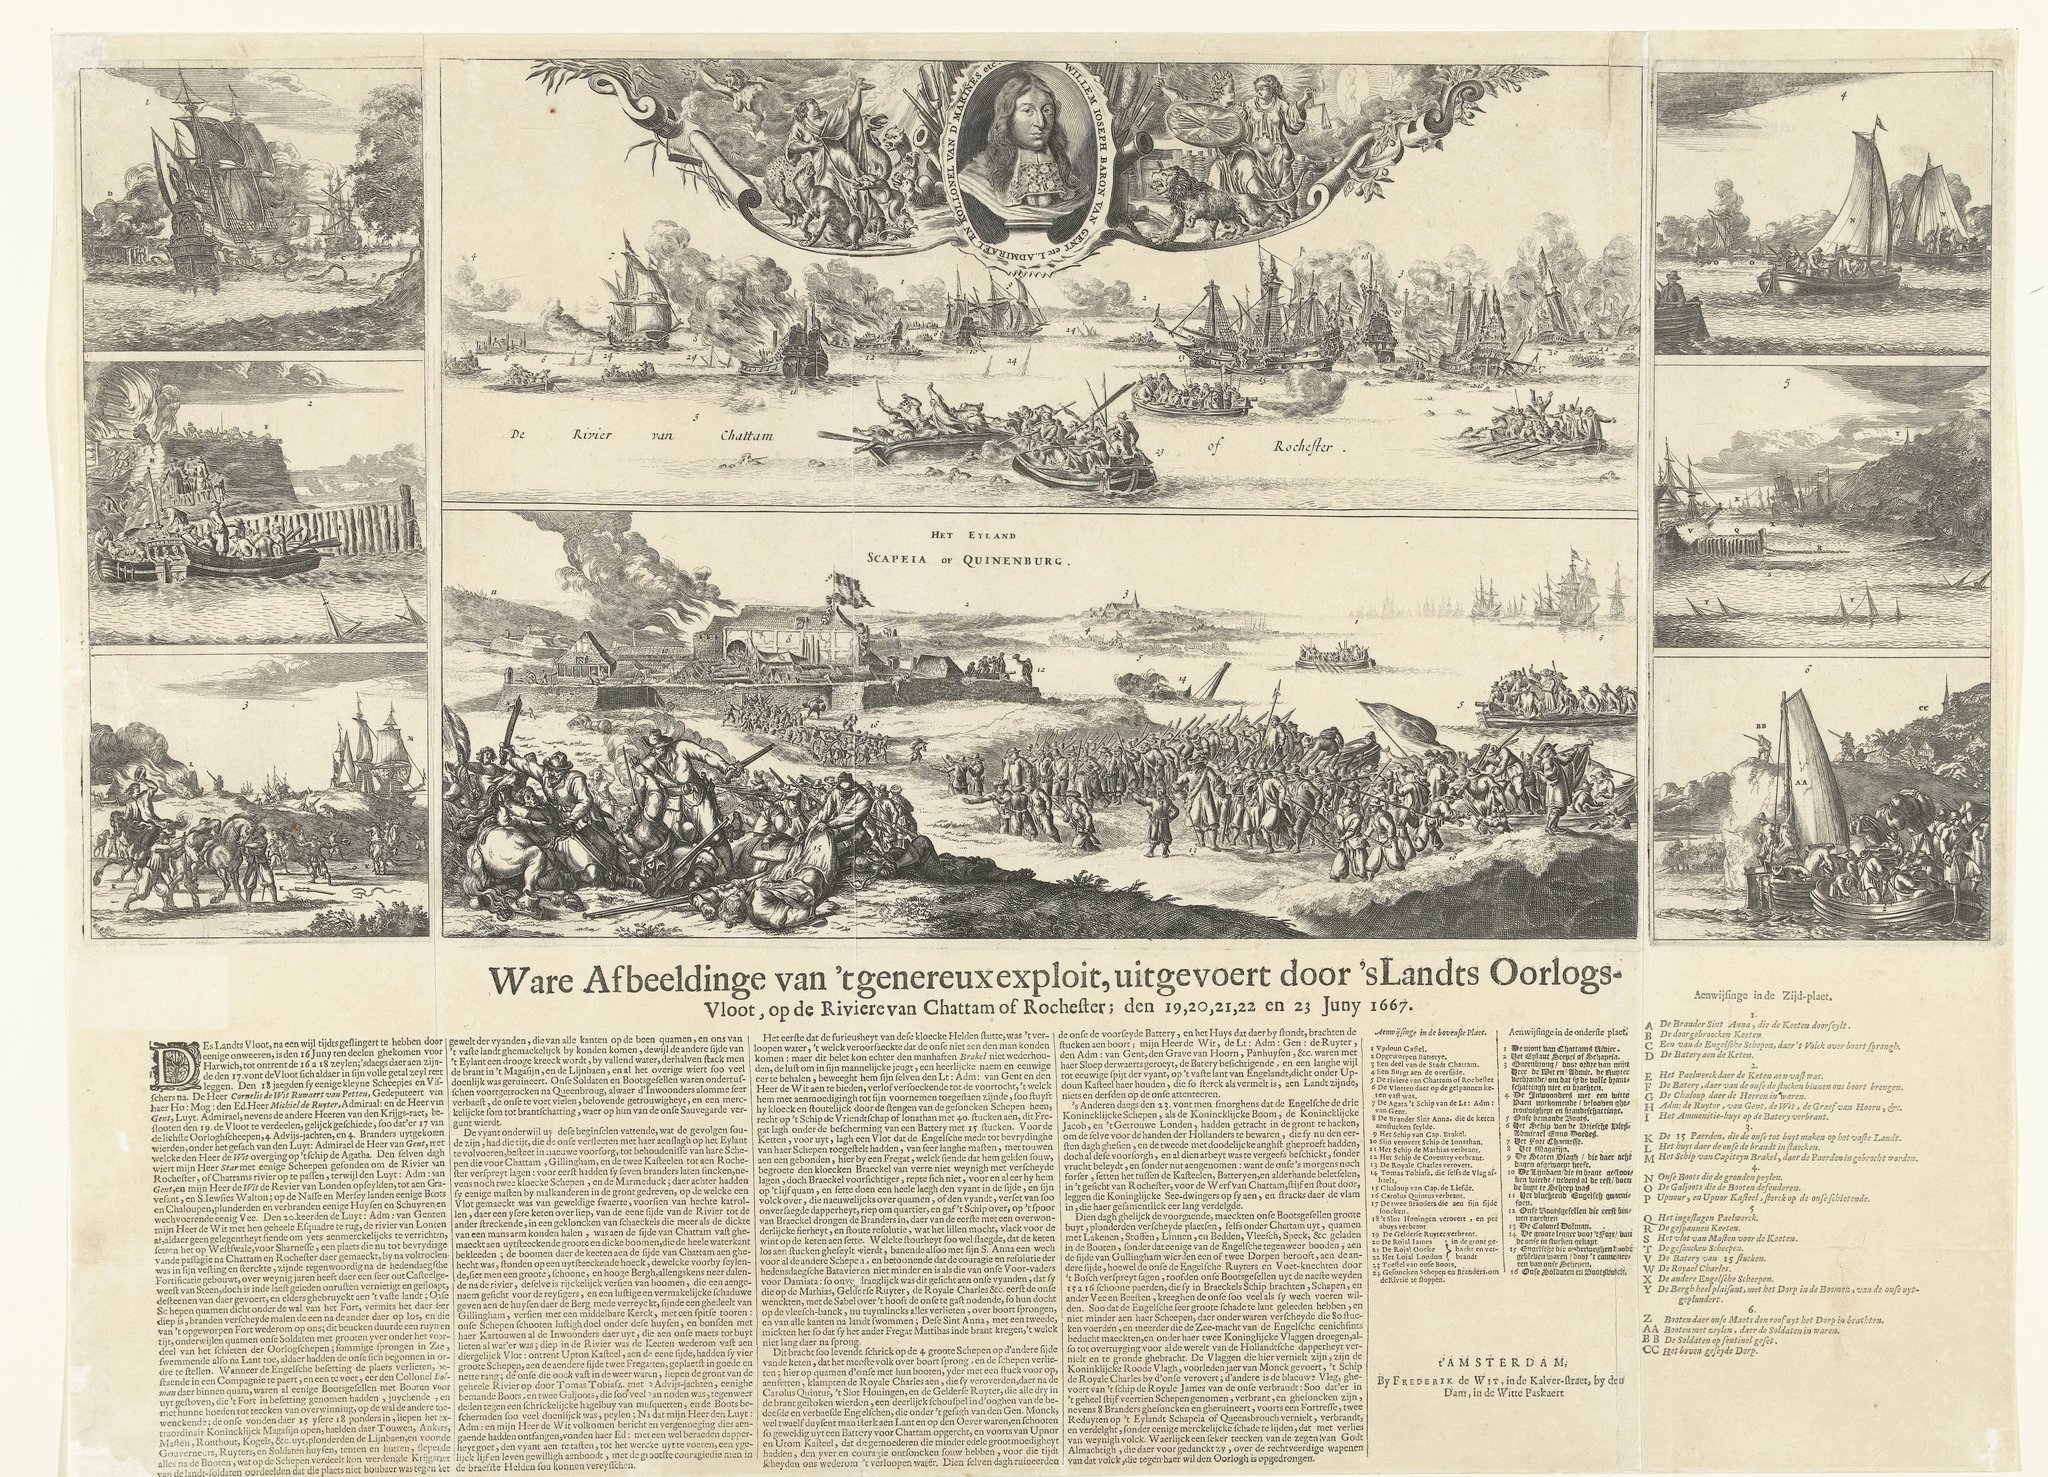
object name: print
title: Ware Af-beeldinge van 't genereux exploit, uitgevoert door 's Landts Oorlogs-Vloot, op de Riviere van Chattam of Rochester; den 19, 20, 21, 22, en 23 Juny 1667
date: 1667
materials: paper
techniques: engraving, etching, letterpress printing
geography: northern netherlands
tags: flushing, michiel adriaenszoon de ruyter, willem joseph baron van gendt, battle (+ naval force), capture of city (after the siege), raid on the medway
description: Blad met centraal twee voorstellingen en aan weerszijden zes kleine scènes 1-6 van de gebeurtenissen tijdens de tocht naar Chatham. Bovenaan de vernietiging van de Engelse vloot op 20 juni 1667 door de Staatse vloot onder Michiel Adriaenszoon de Ruyter, met een portret van Willem Joseph Baron van Ghendt. Onder een voorstelling van de verovering van het eiland Sheppey met het fort en magazijn te Sheerness door de troepen van kolonel Dolman. Onderaan een beschrijving van de gebeurtenissen in 4 kolommen met hierbij de legenda's voor de centrale platen 1-24 en 1-16 en de zijplaat A-CC in het Nederlands. De drie scènes 4-6 aan de rechterzijde gedrukt op een apart blad maar vastgeplakt aan het geheel.